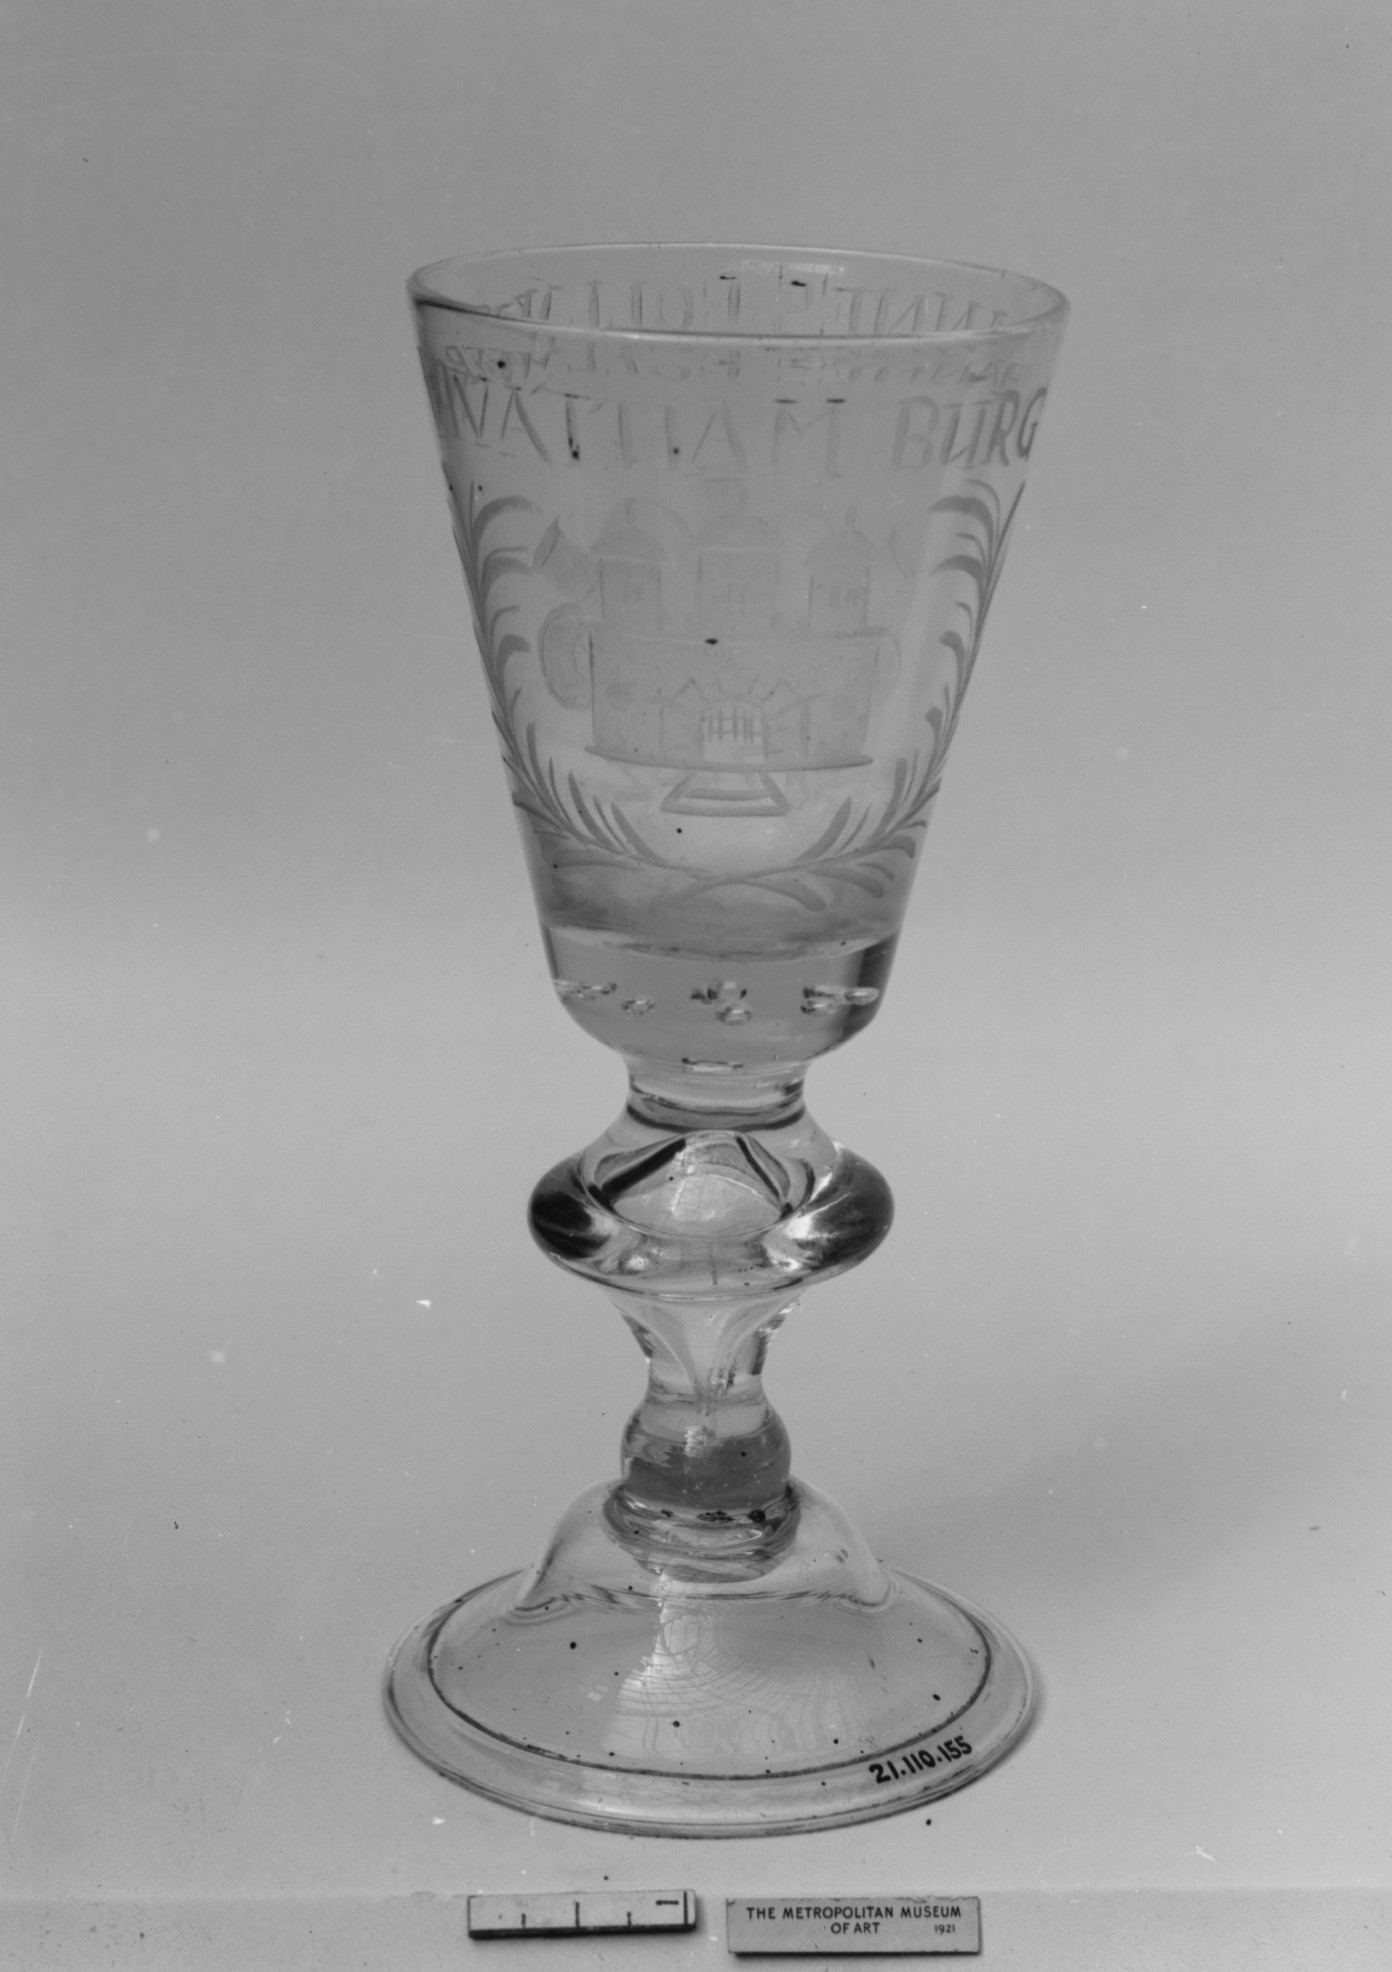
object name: wineglass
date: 1750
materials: glass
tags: houses